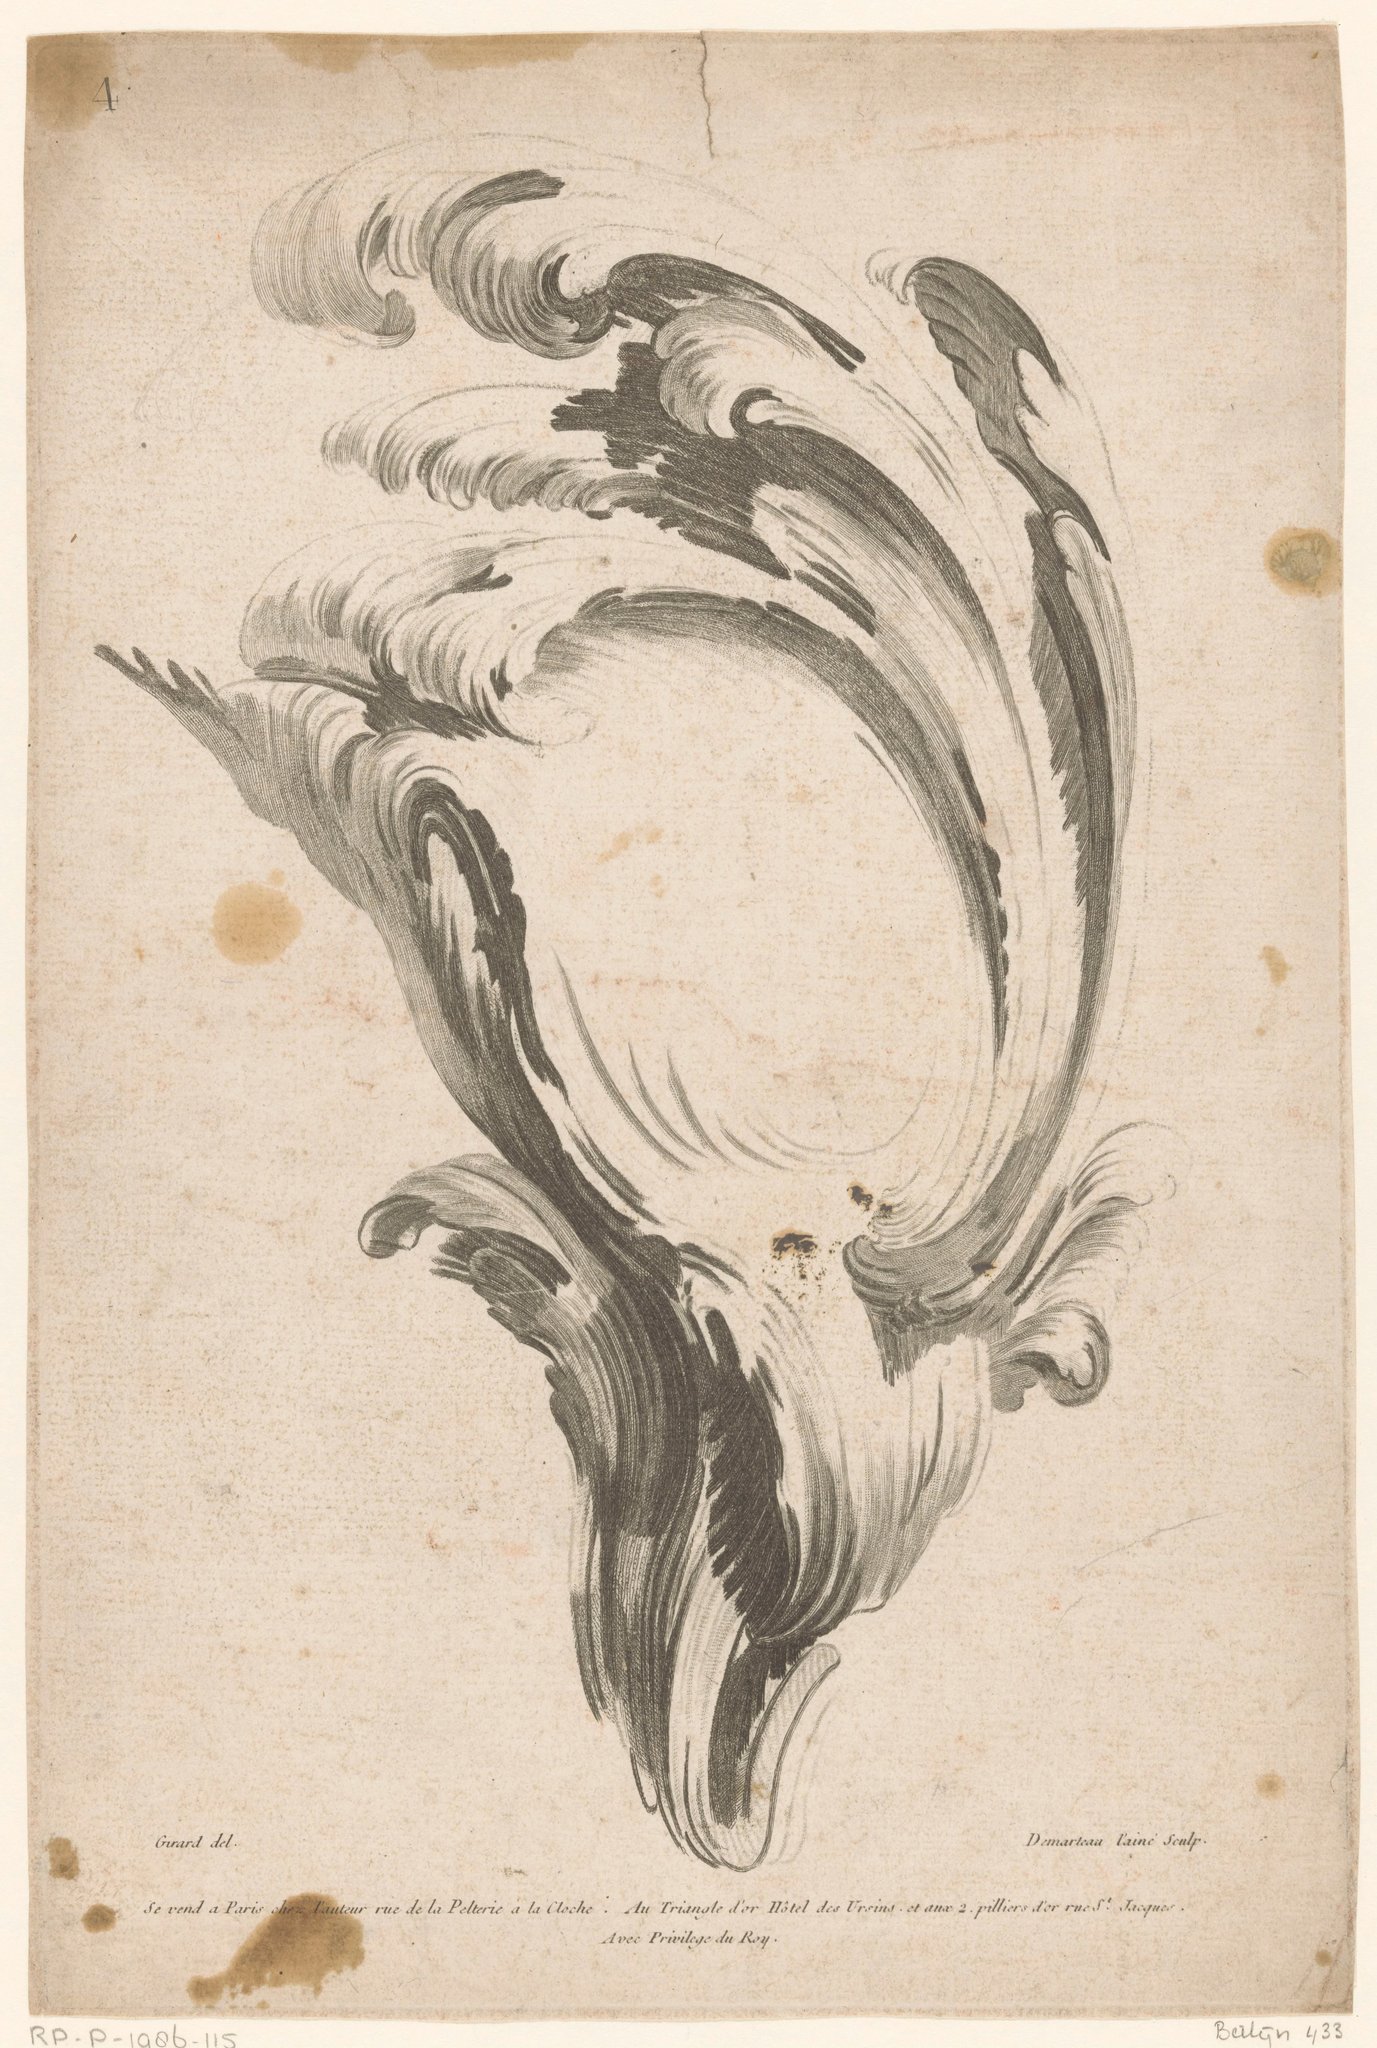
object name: print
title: Rocaille cartouche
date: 1761-1769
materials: paper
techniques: etching, roulette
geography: paris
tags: rocaille ornament, ornament ~ cartouche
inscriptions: collector's mark: Lugt 2228, collector's mark: Lugt 2760